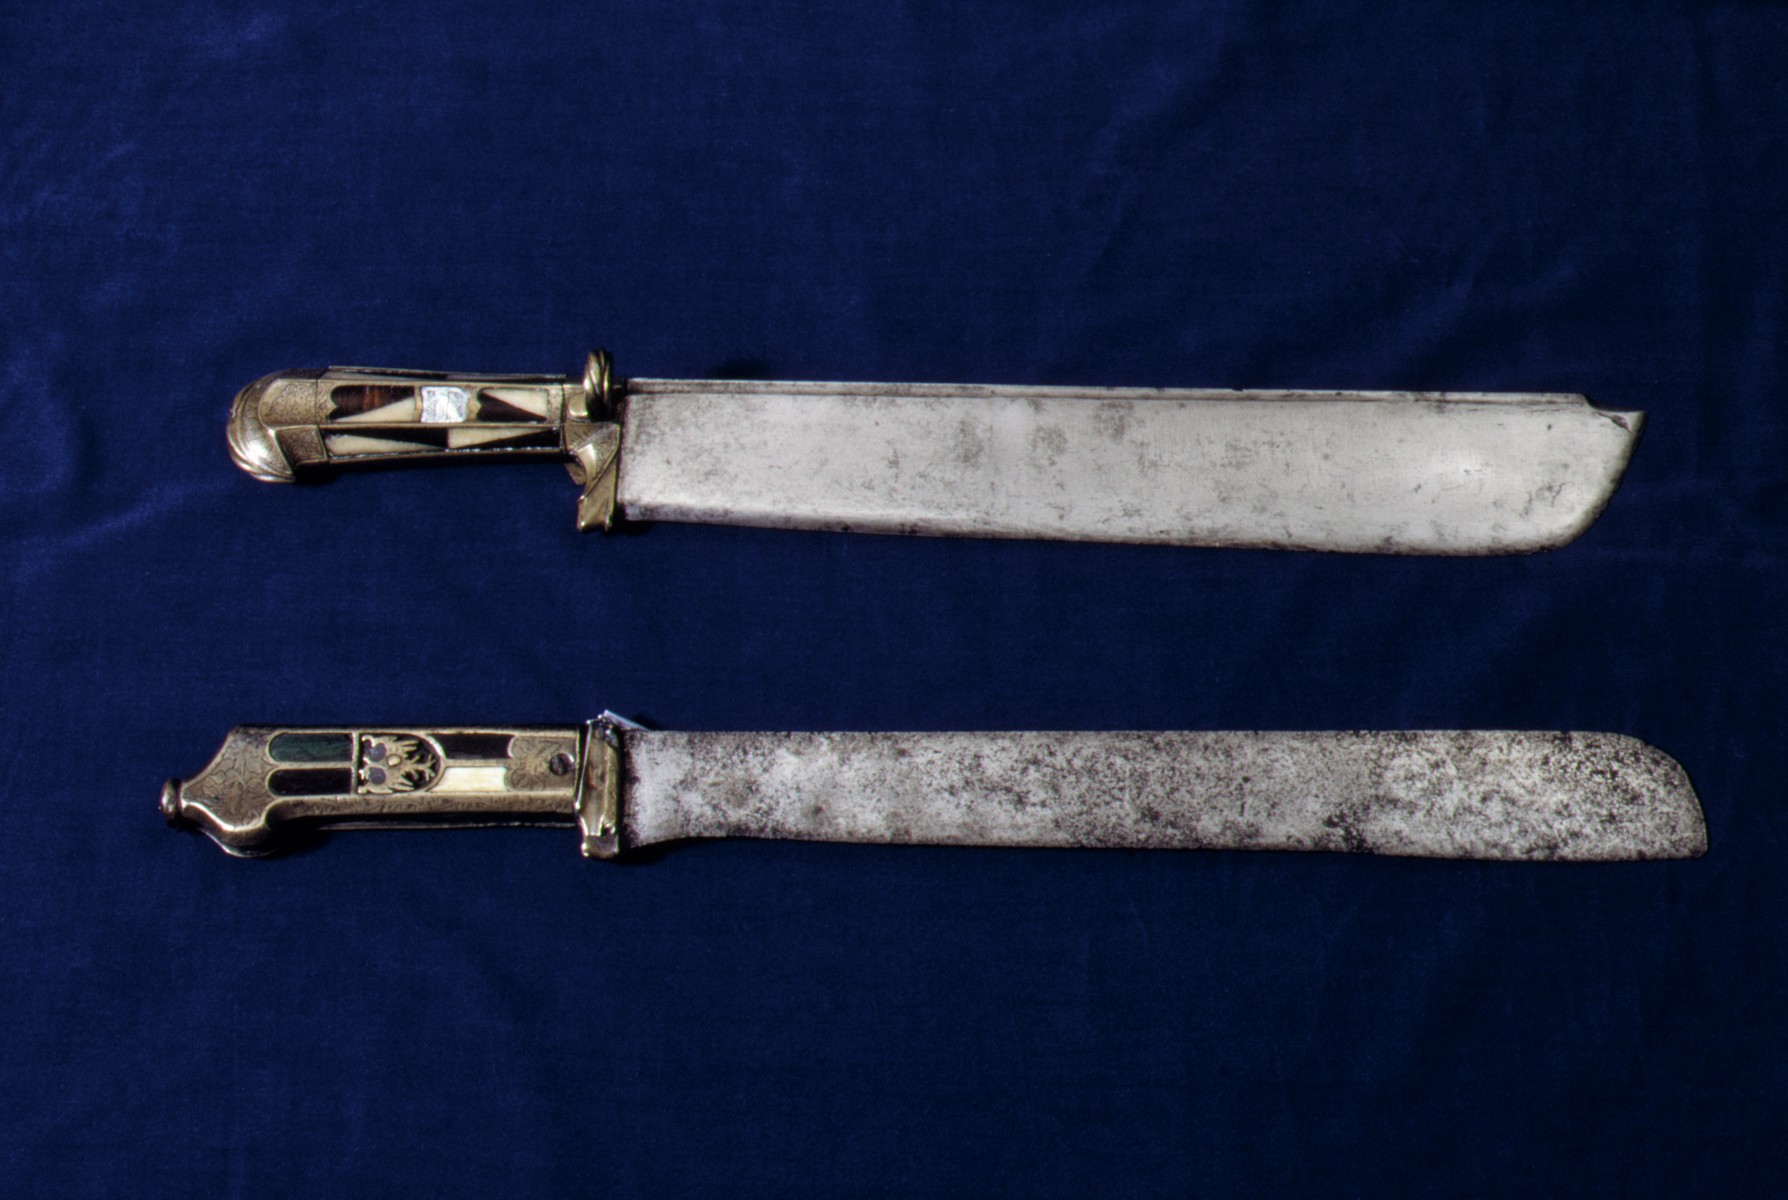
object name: hunting knife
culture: austrian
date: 1500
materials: bone, brass, steel, wood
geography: austria